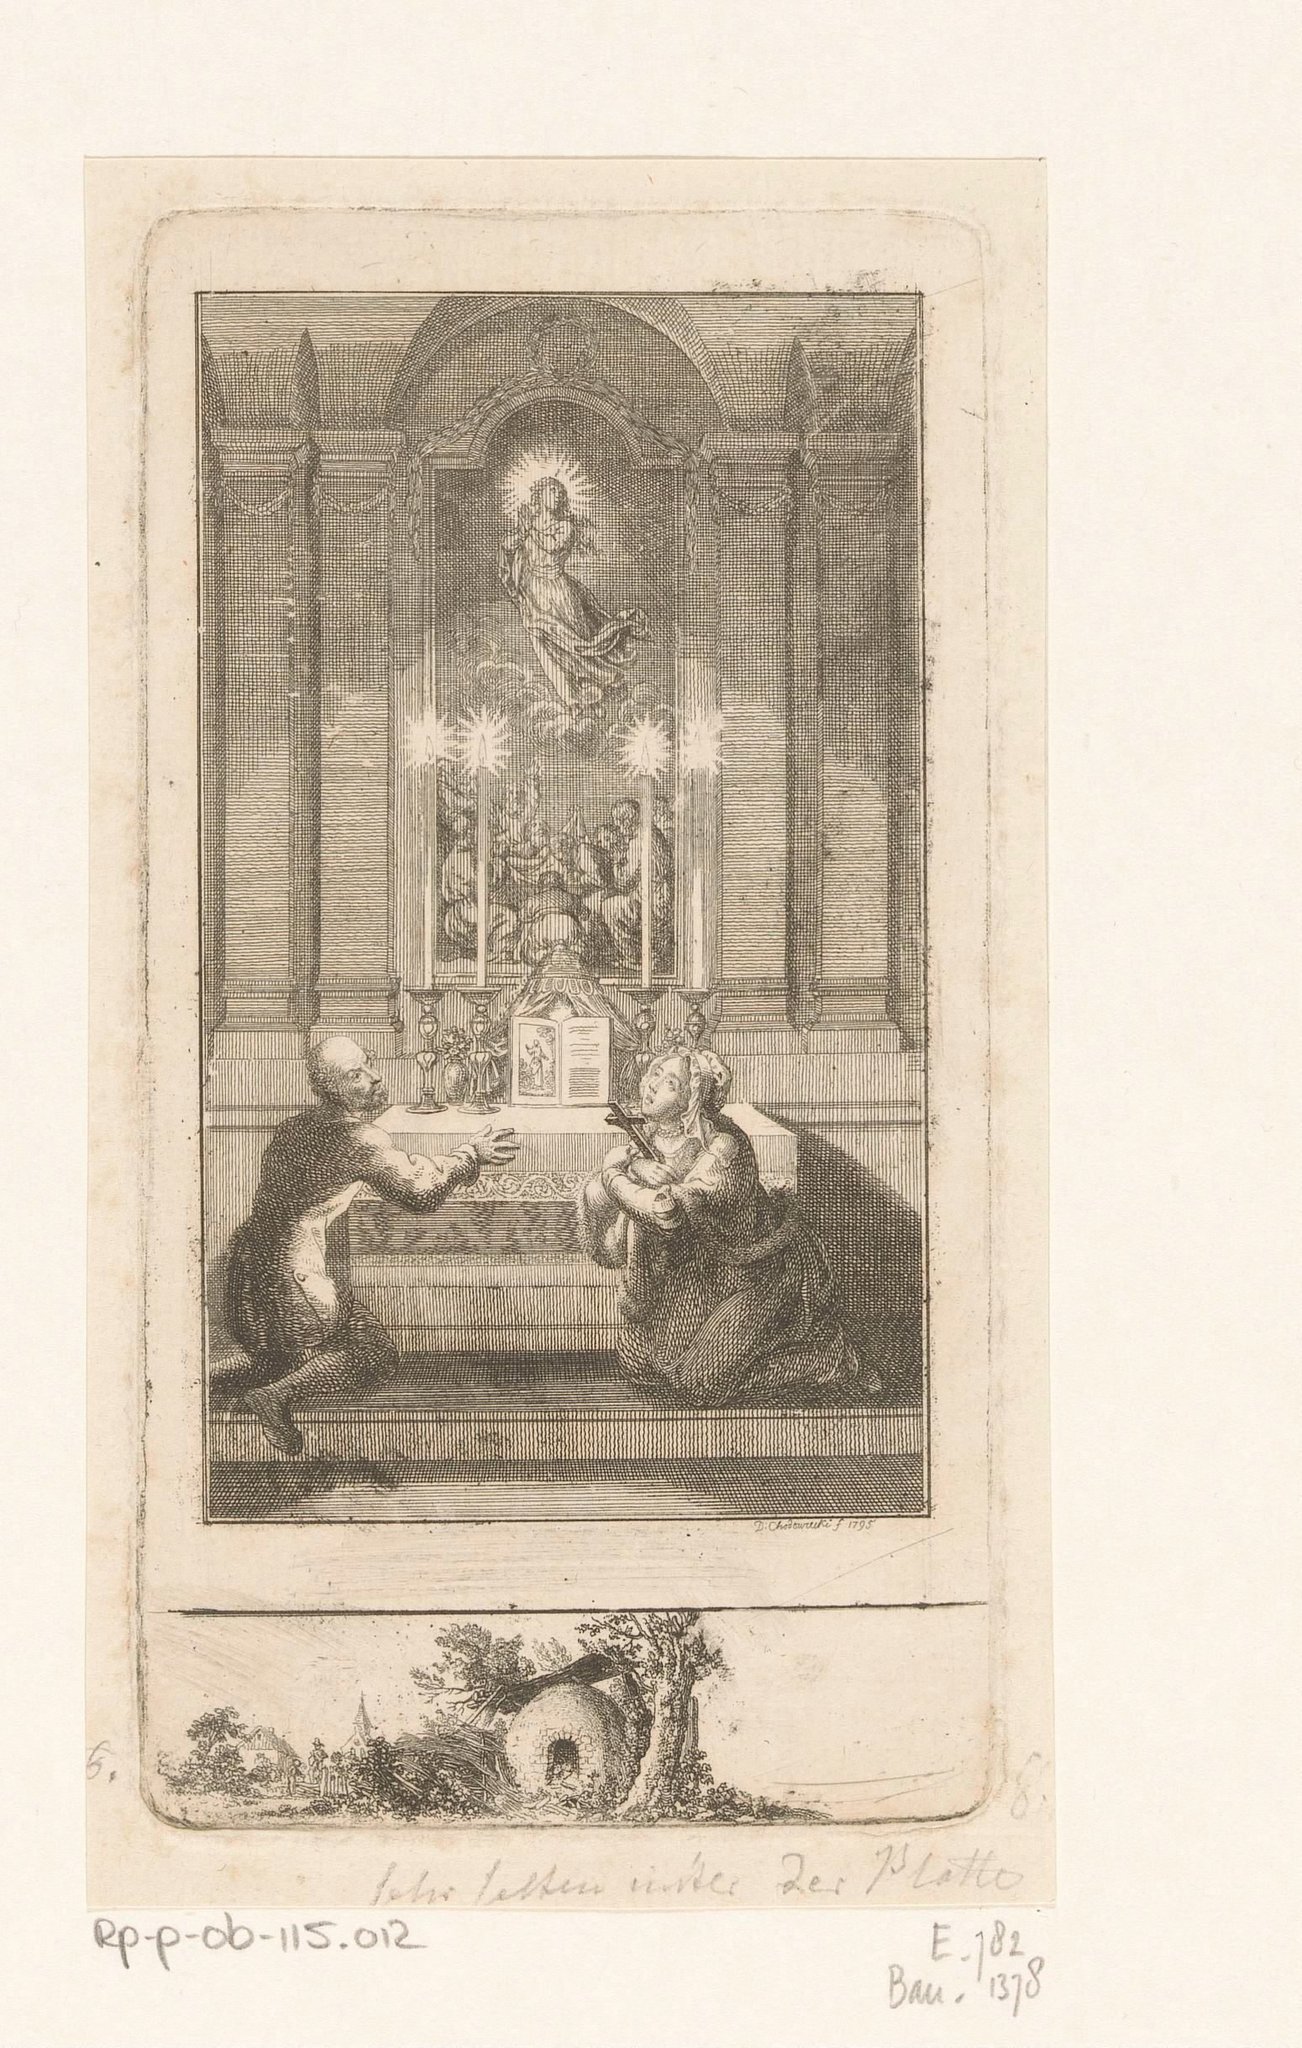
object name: print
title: Adelgunde toont berouw bij het altaar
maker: daniel nikolaus chodowiecki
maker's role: draughtsman, print maker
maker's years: 1726-1801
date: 1795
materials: paper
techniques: etching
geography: berlin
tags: literature, penitence, repentance; 'penitenza', 'pentimento', 'pentimento de'peccati', 'purgatione de peccati' (ripa), altar with altar-piece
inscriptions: collector's mark: Lugt 2228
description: Latere staat gebruikt voor: Wächter, Leonhard. Sagen der Vorzeit von Veit Weber. 5 dln. Berlijn: Friedrich Maurer, 1795, dl. 5.